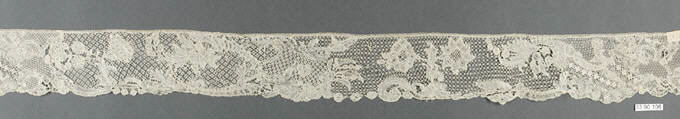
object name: edging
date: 1734-1766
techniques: lace